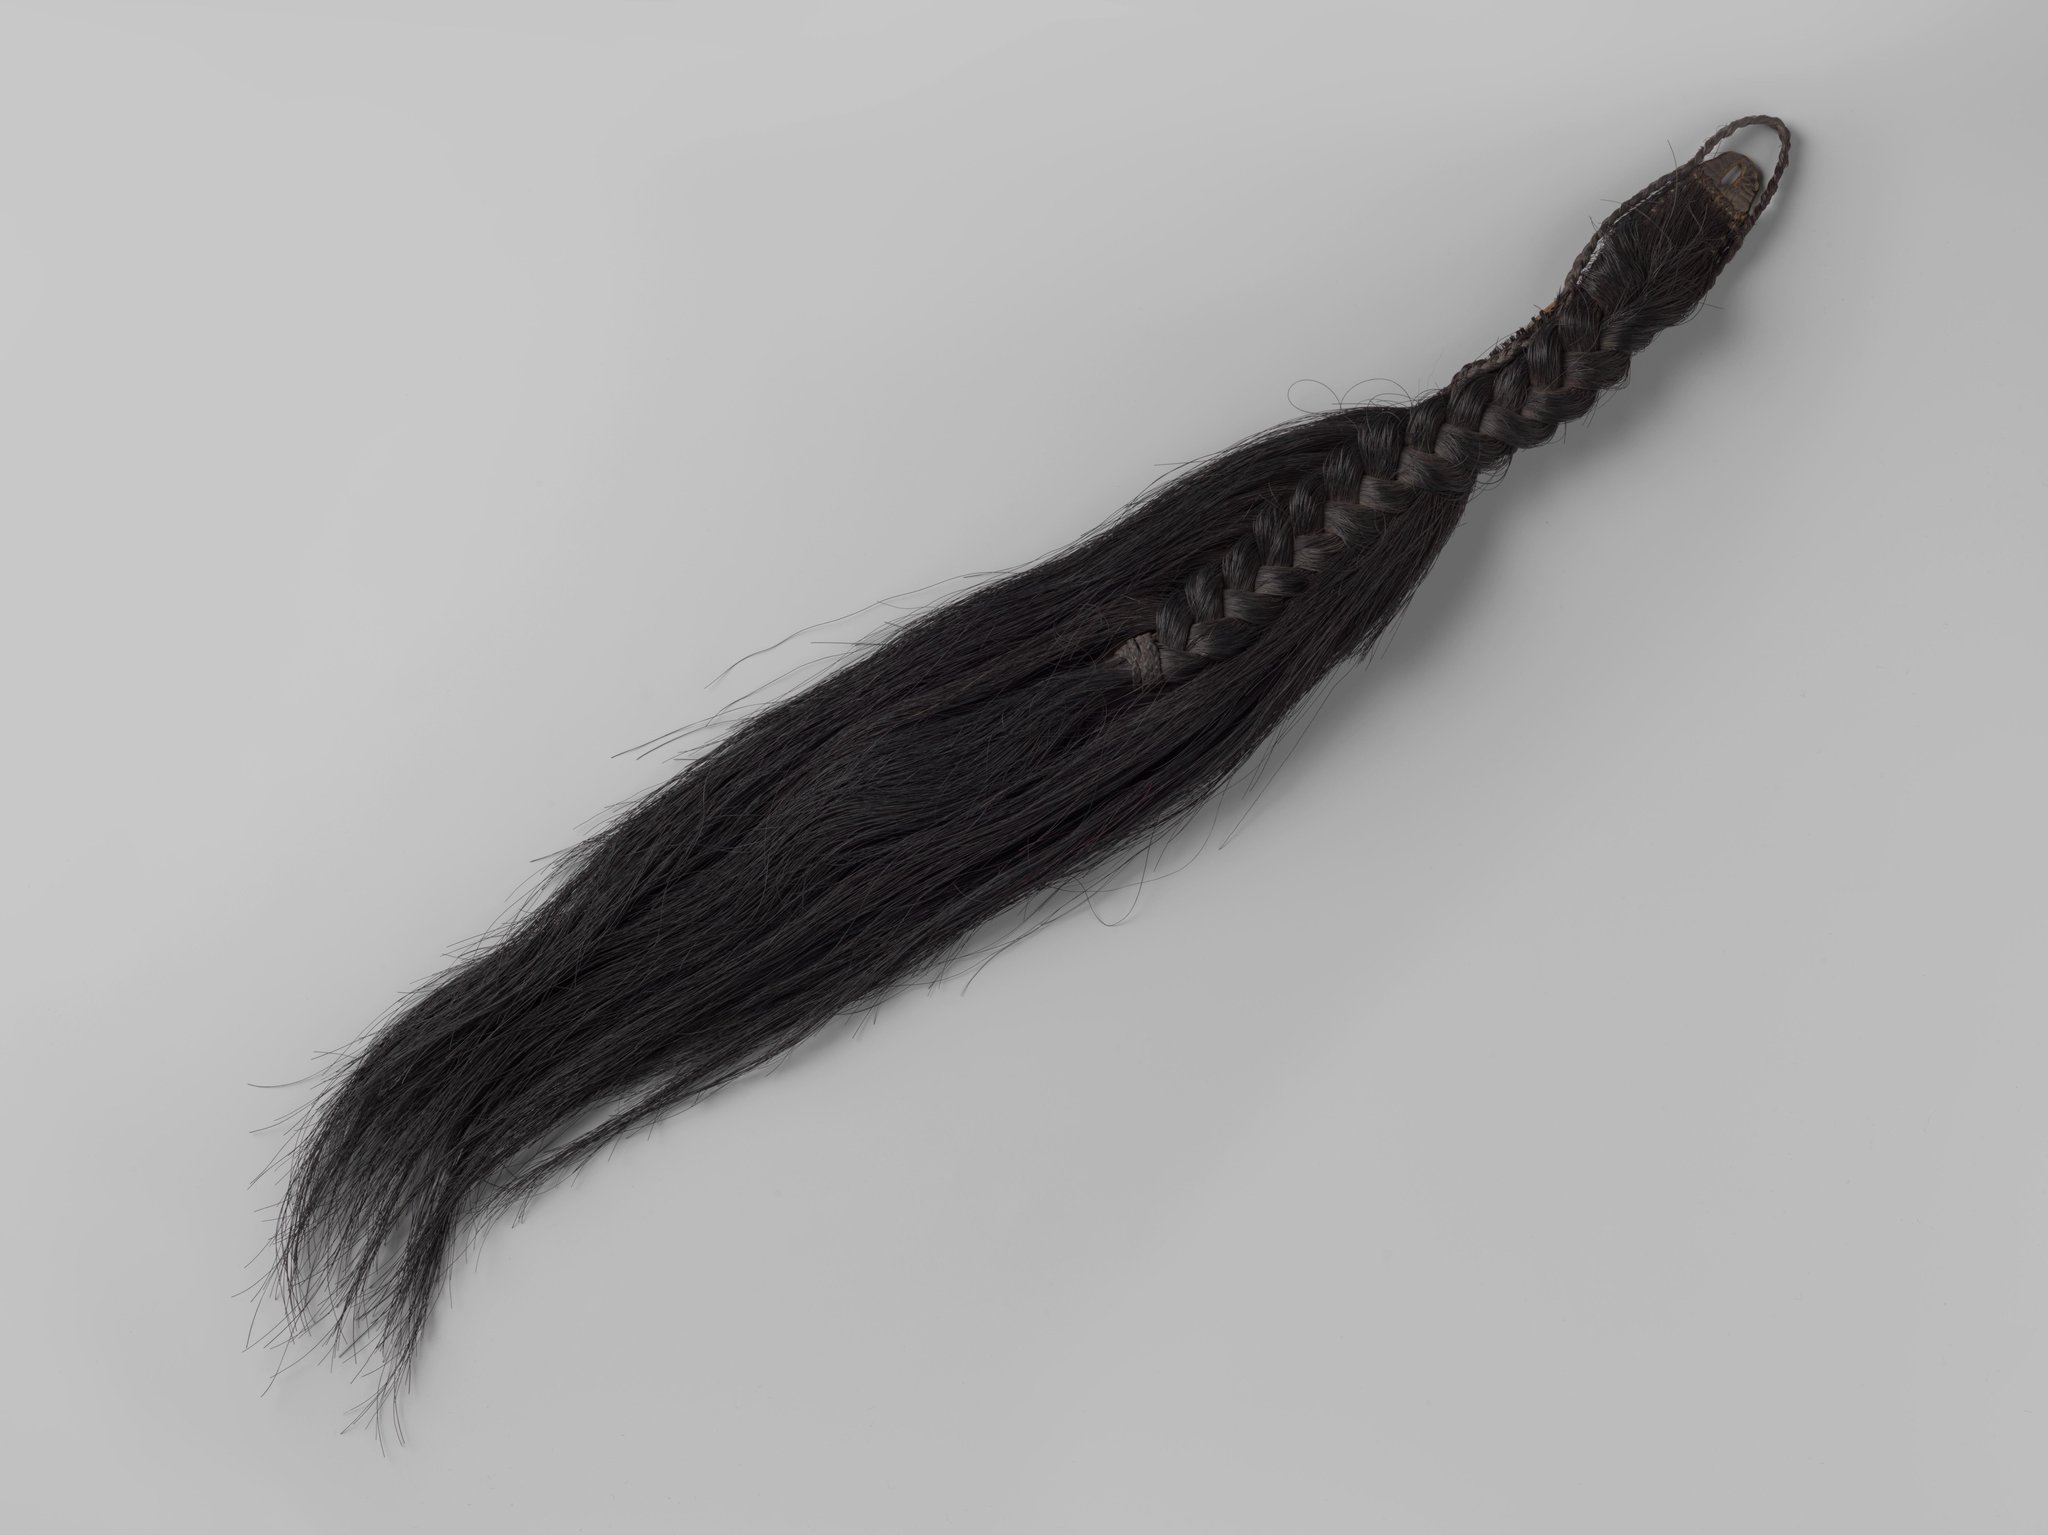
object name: plume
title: Paardenstaart voor lichte of zware dragonderhelm M 1838-1845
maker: Anonymous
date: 1800-1850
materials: copper, hair, iron, leather, yarns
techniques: braiding, sewing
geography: netherlands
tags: netherlands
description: Gevlochten zwarte paardenharen pluim op een strook zwart leer bevestigd. Op het leer aan de achterkant dubbele koperen haak nr. 11649 en leren riempje met metalen gesp. Aan paardenharen lus bovenzijde label: Roosdorp L-1, keerzijde NM 11649.